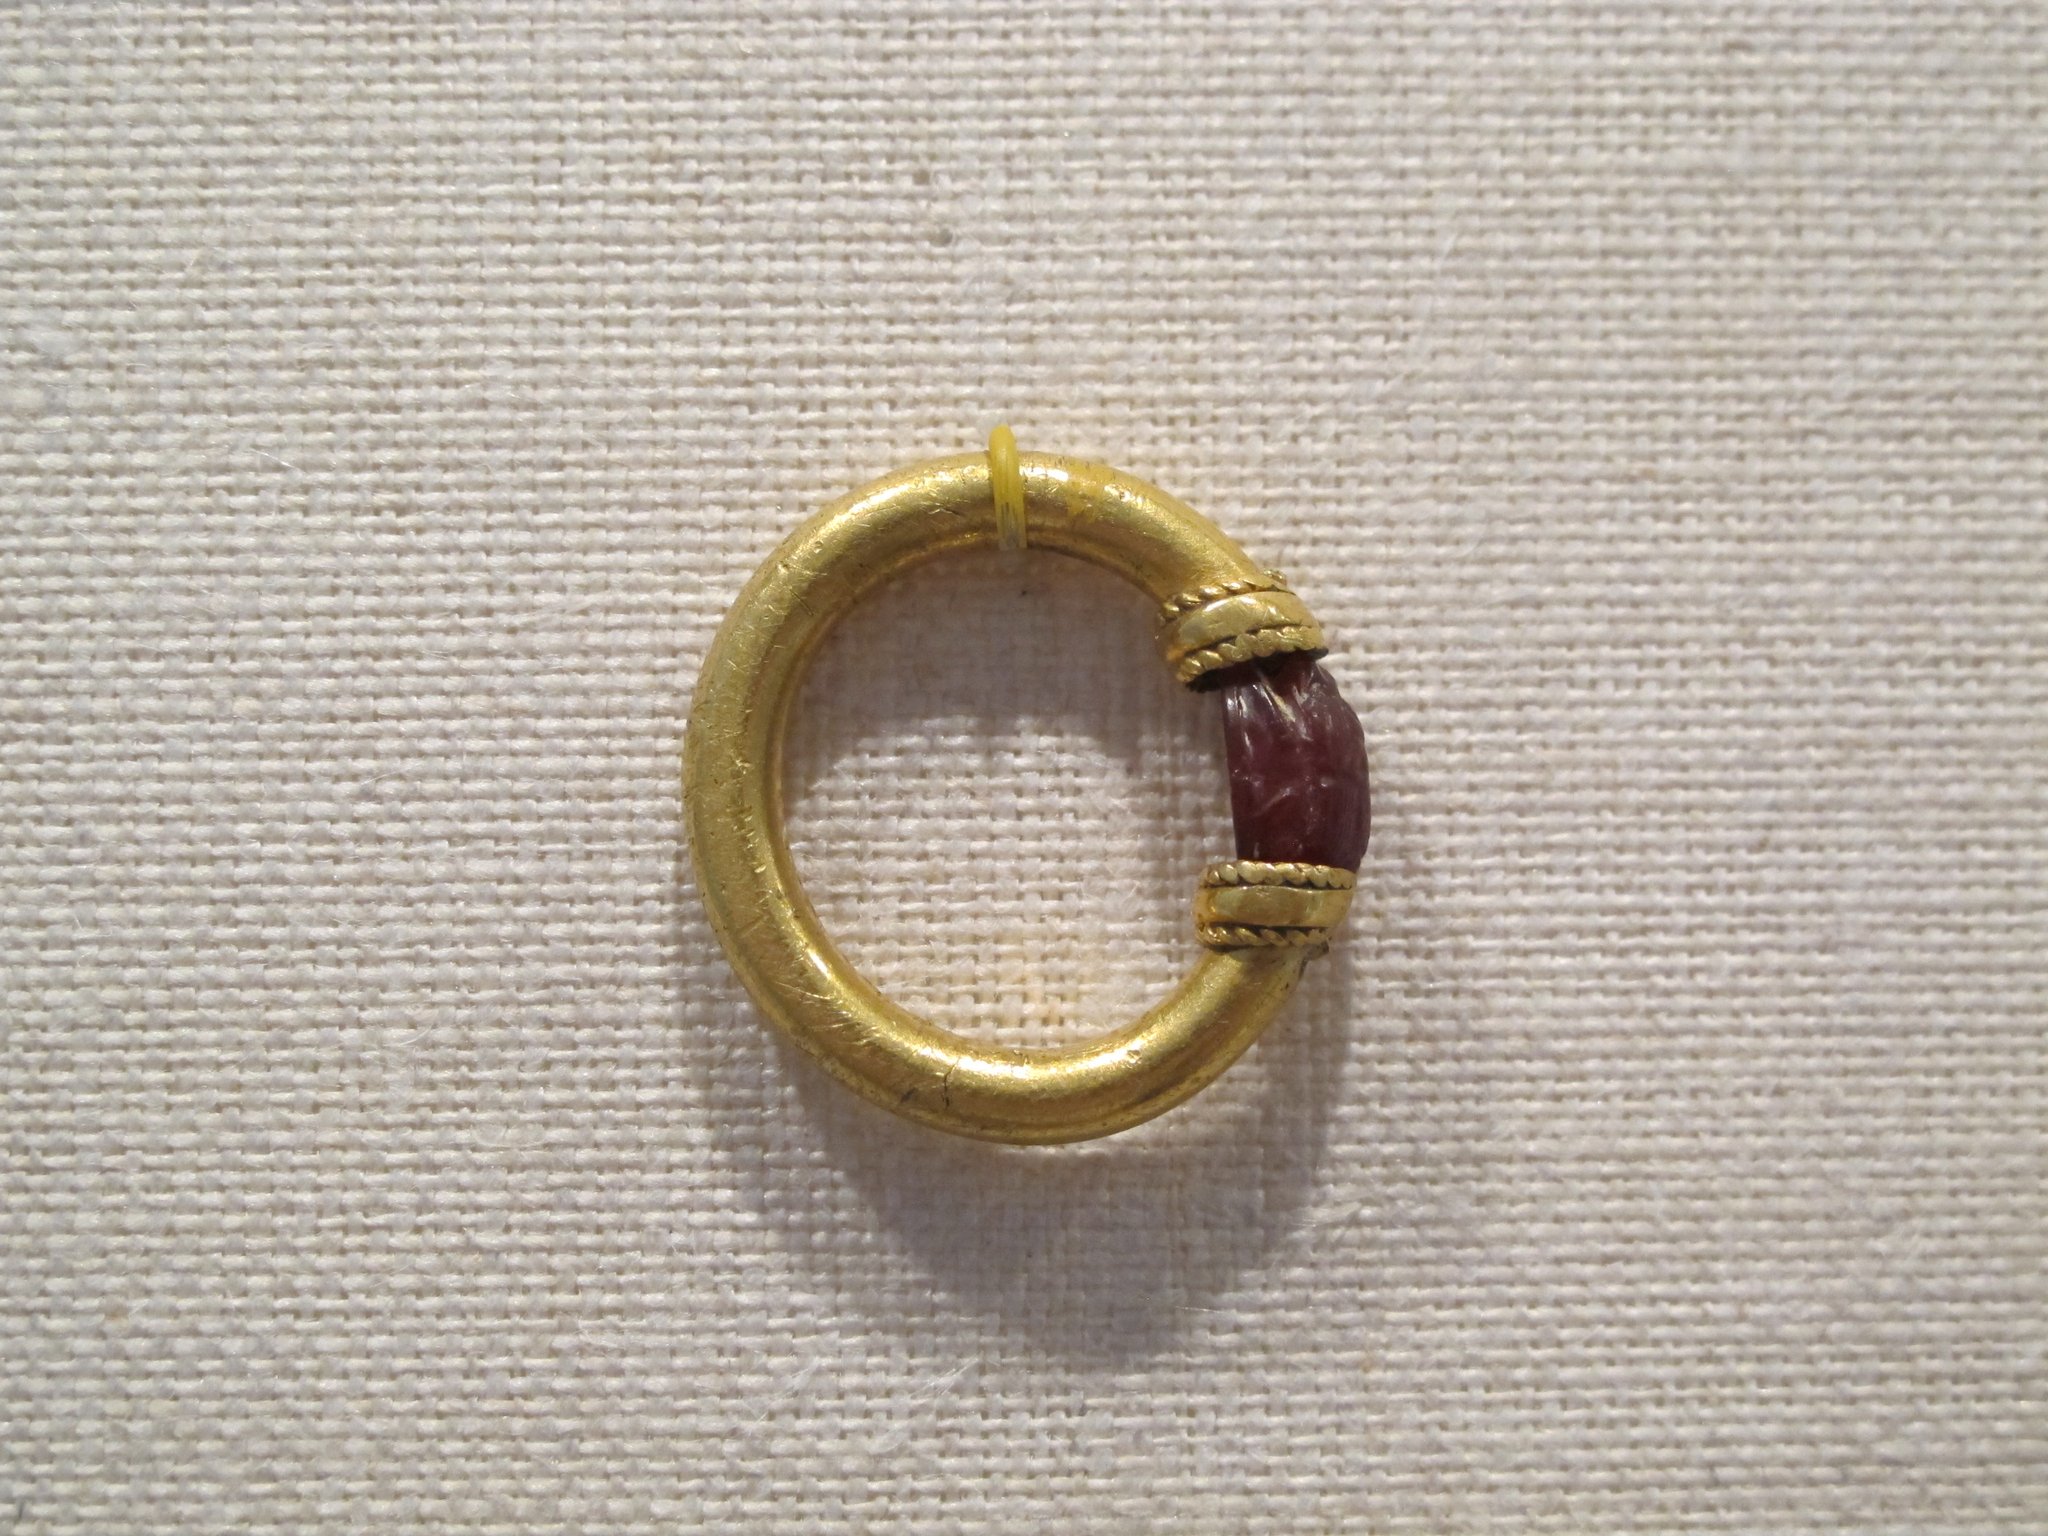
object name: ring with scarab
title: Gold swivel ring with carnelian scarab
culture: etruscan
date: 500-401 BCE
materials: gold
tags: heads,men,scarabs